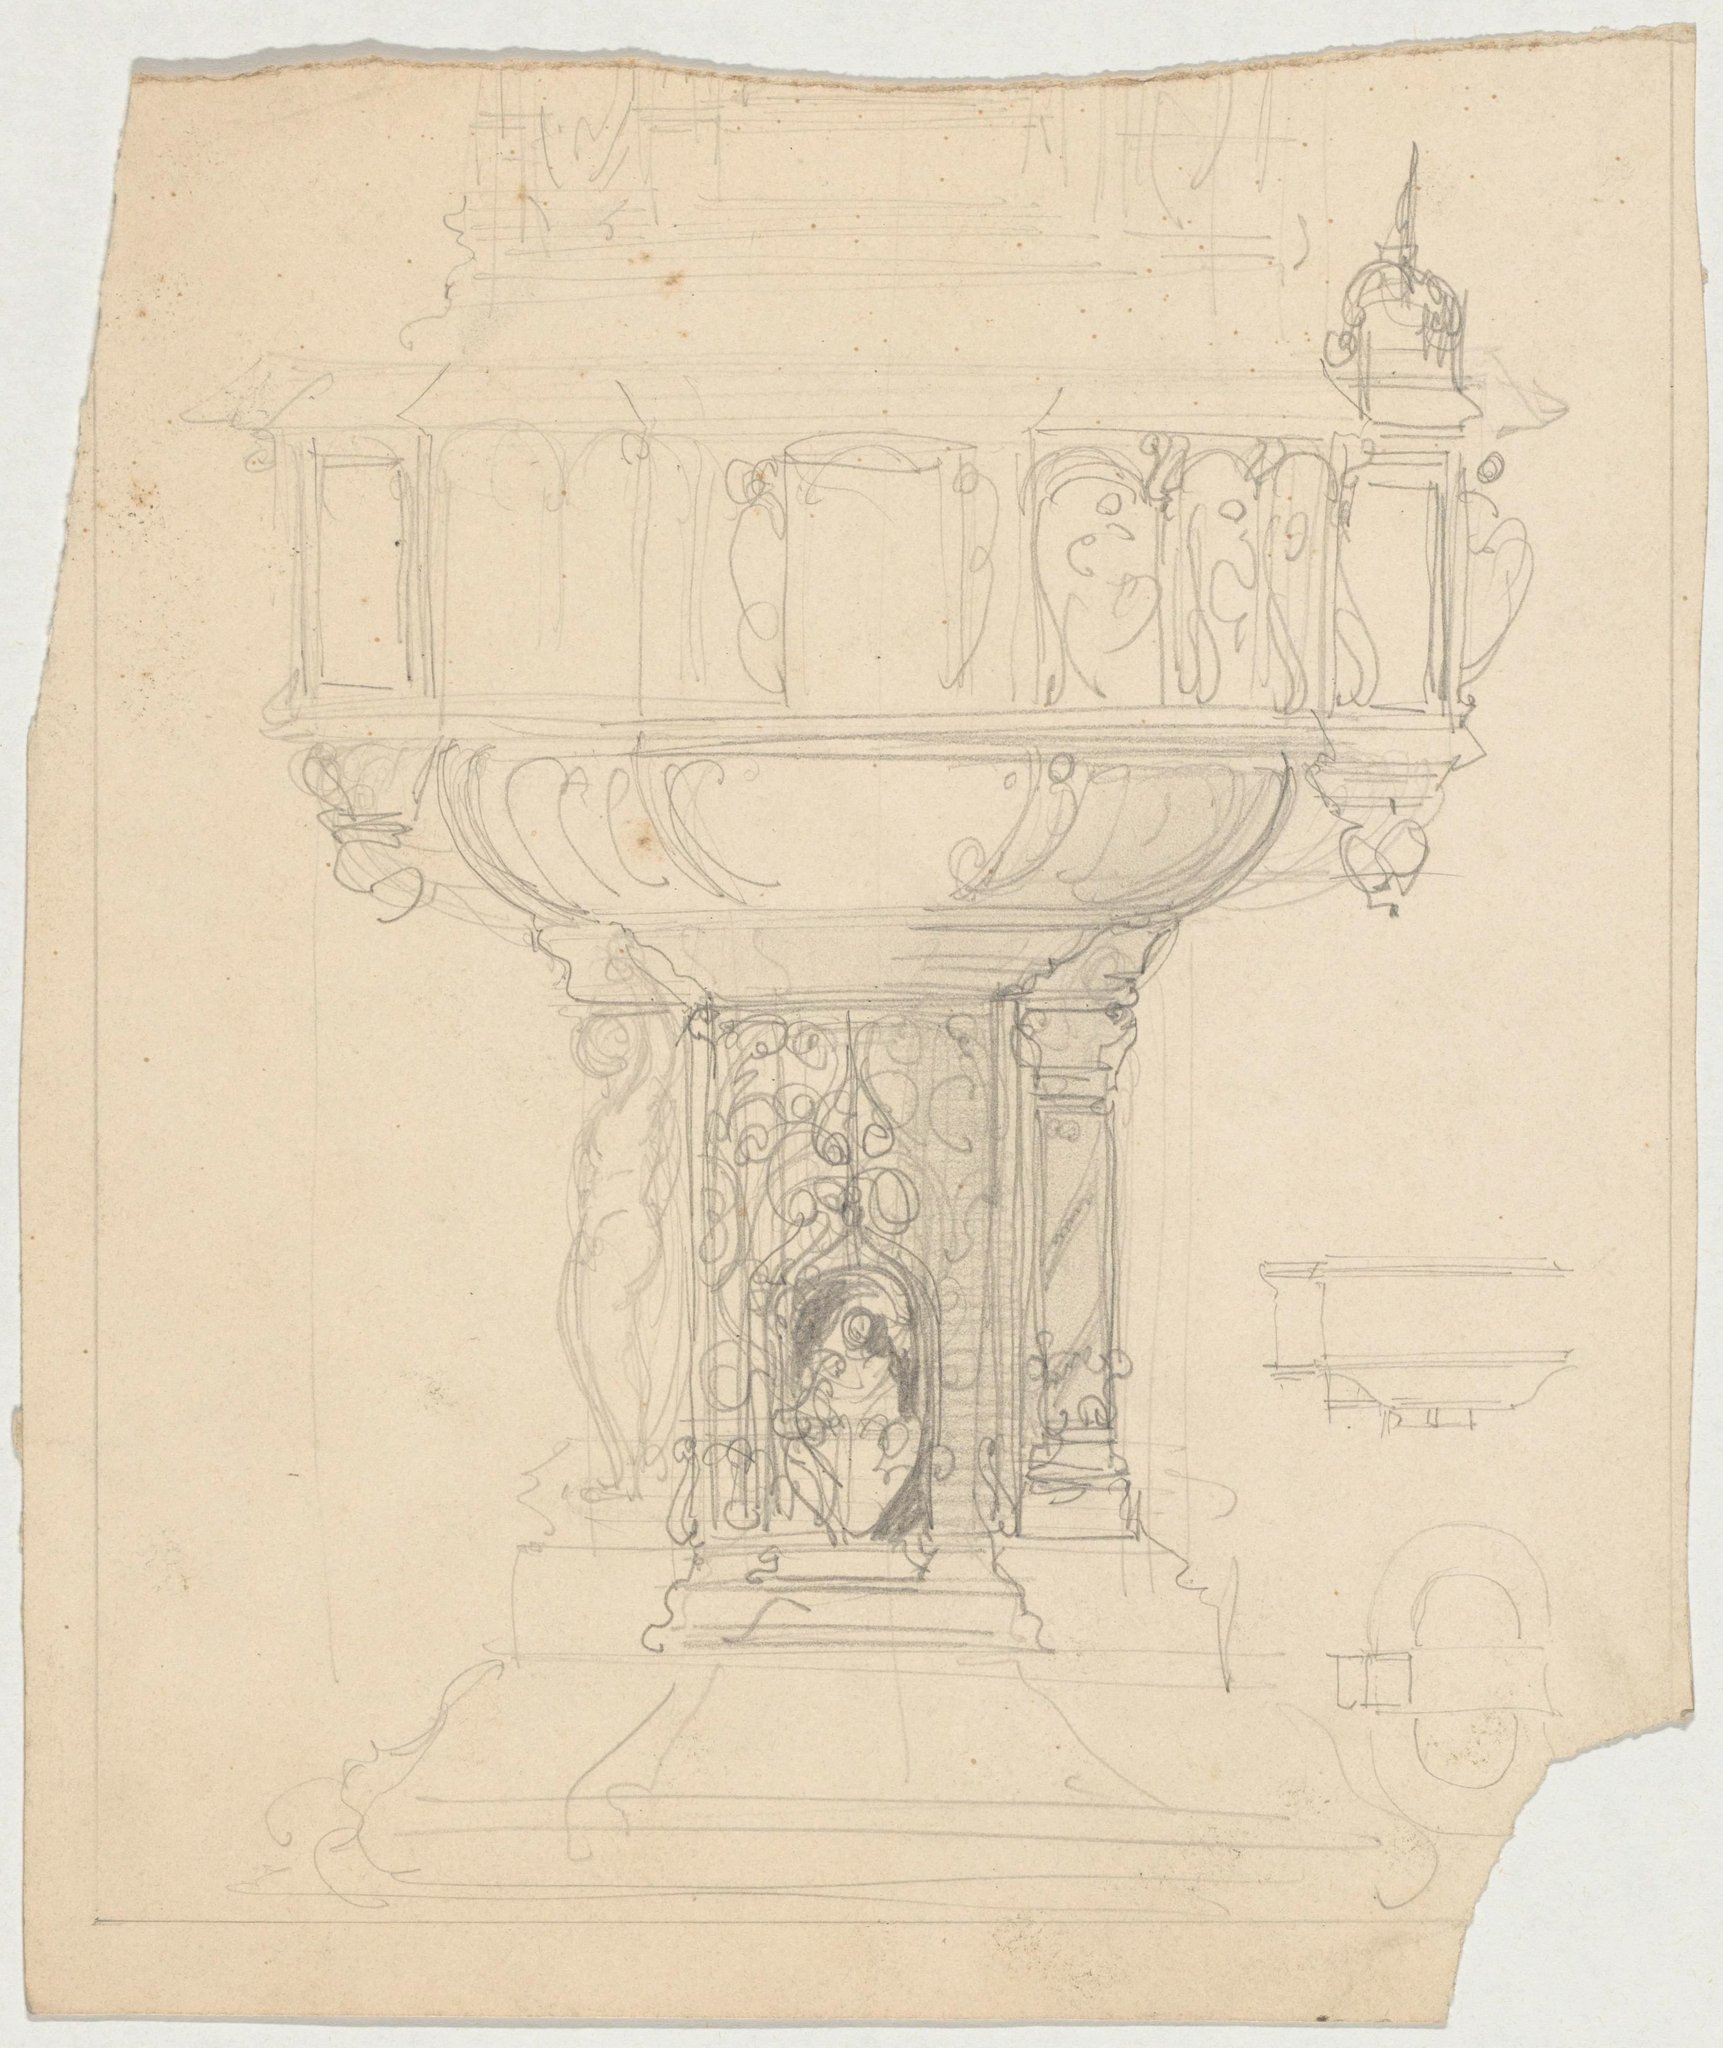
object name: design drawing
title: Tafelstuk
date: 1830-1850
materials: graphite, paper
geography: paris